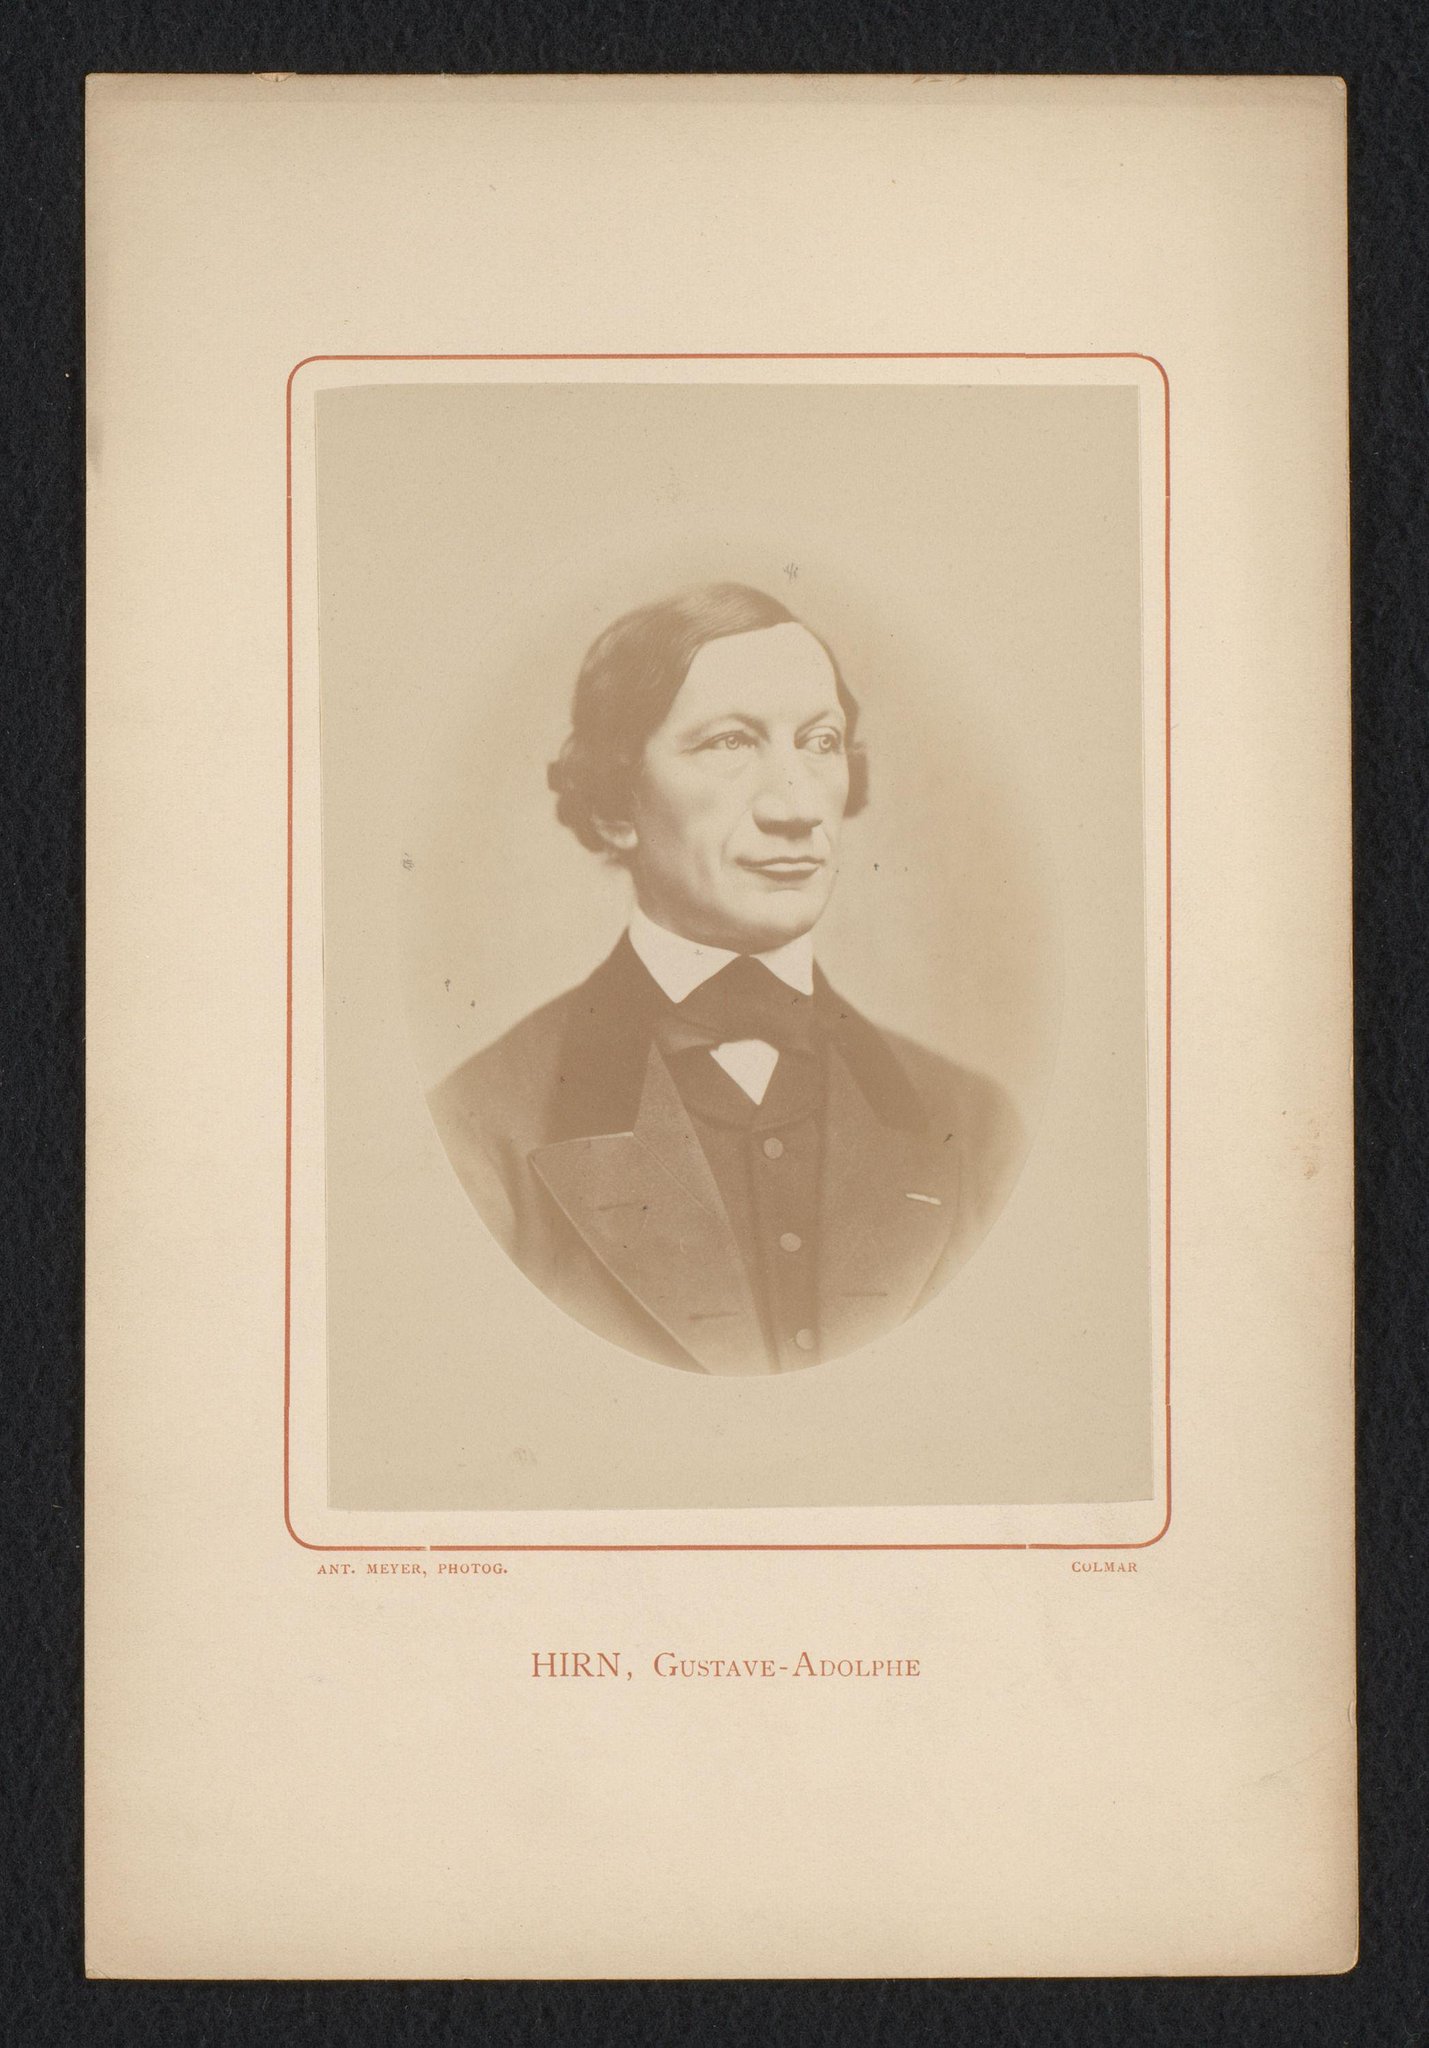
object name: photograph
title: Portret van Gustave-Adolphe Hirn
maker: anton meyer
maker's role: fotograaf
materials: photographic support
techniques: albumen print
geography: colmar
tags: physicist, historical persons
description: Deze foto maakt deel uit van een omslag met 29 foto's op 29 bladen en 23 teksbladen.